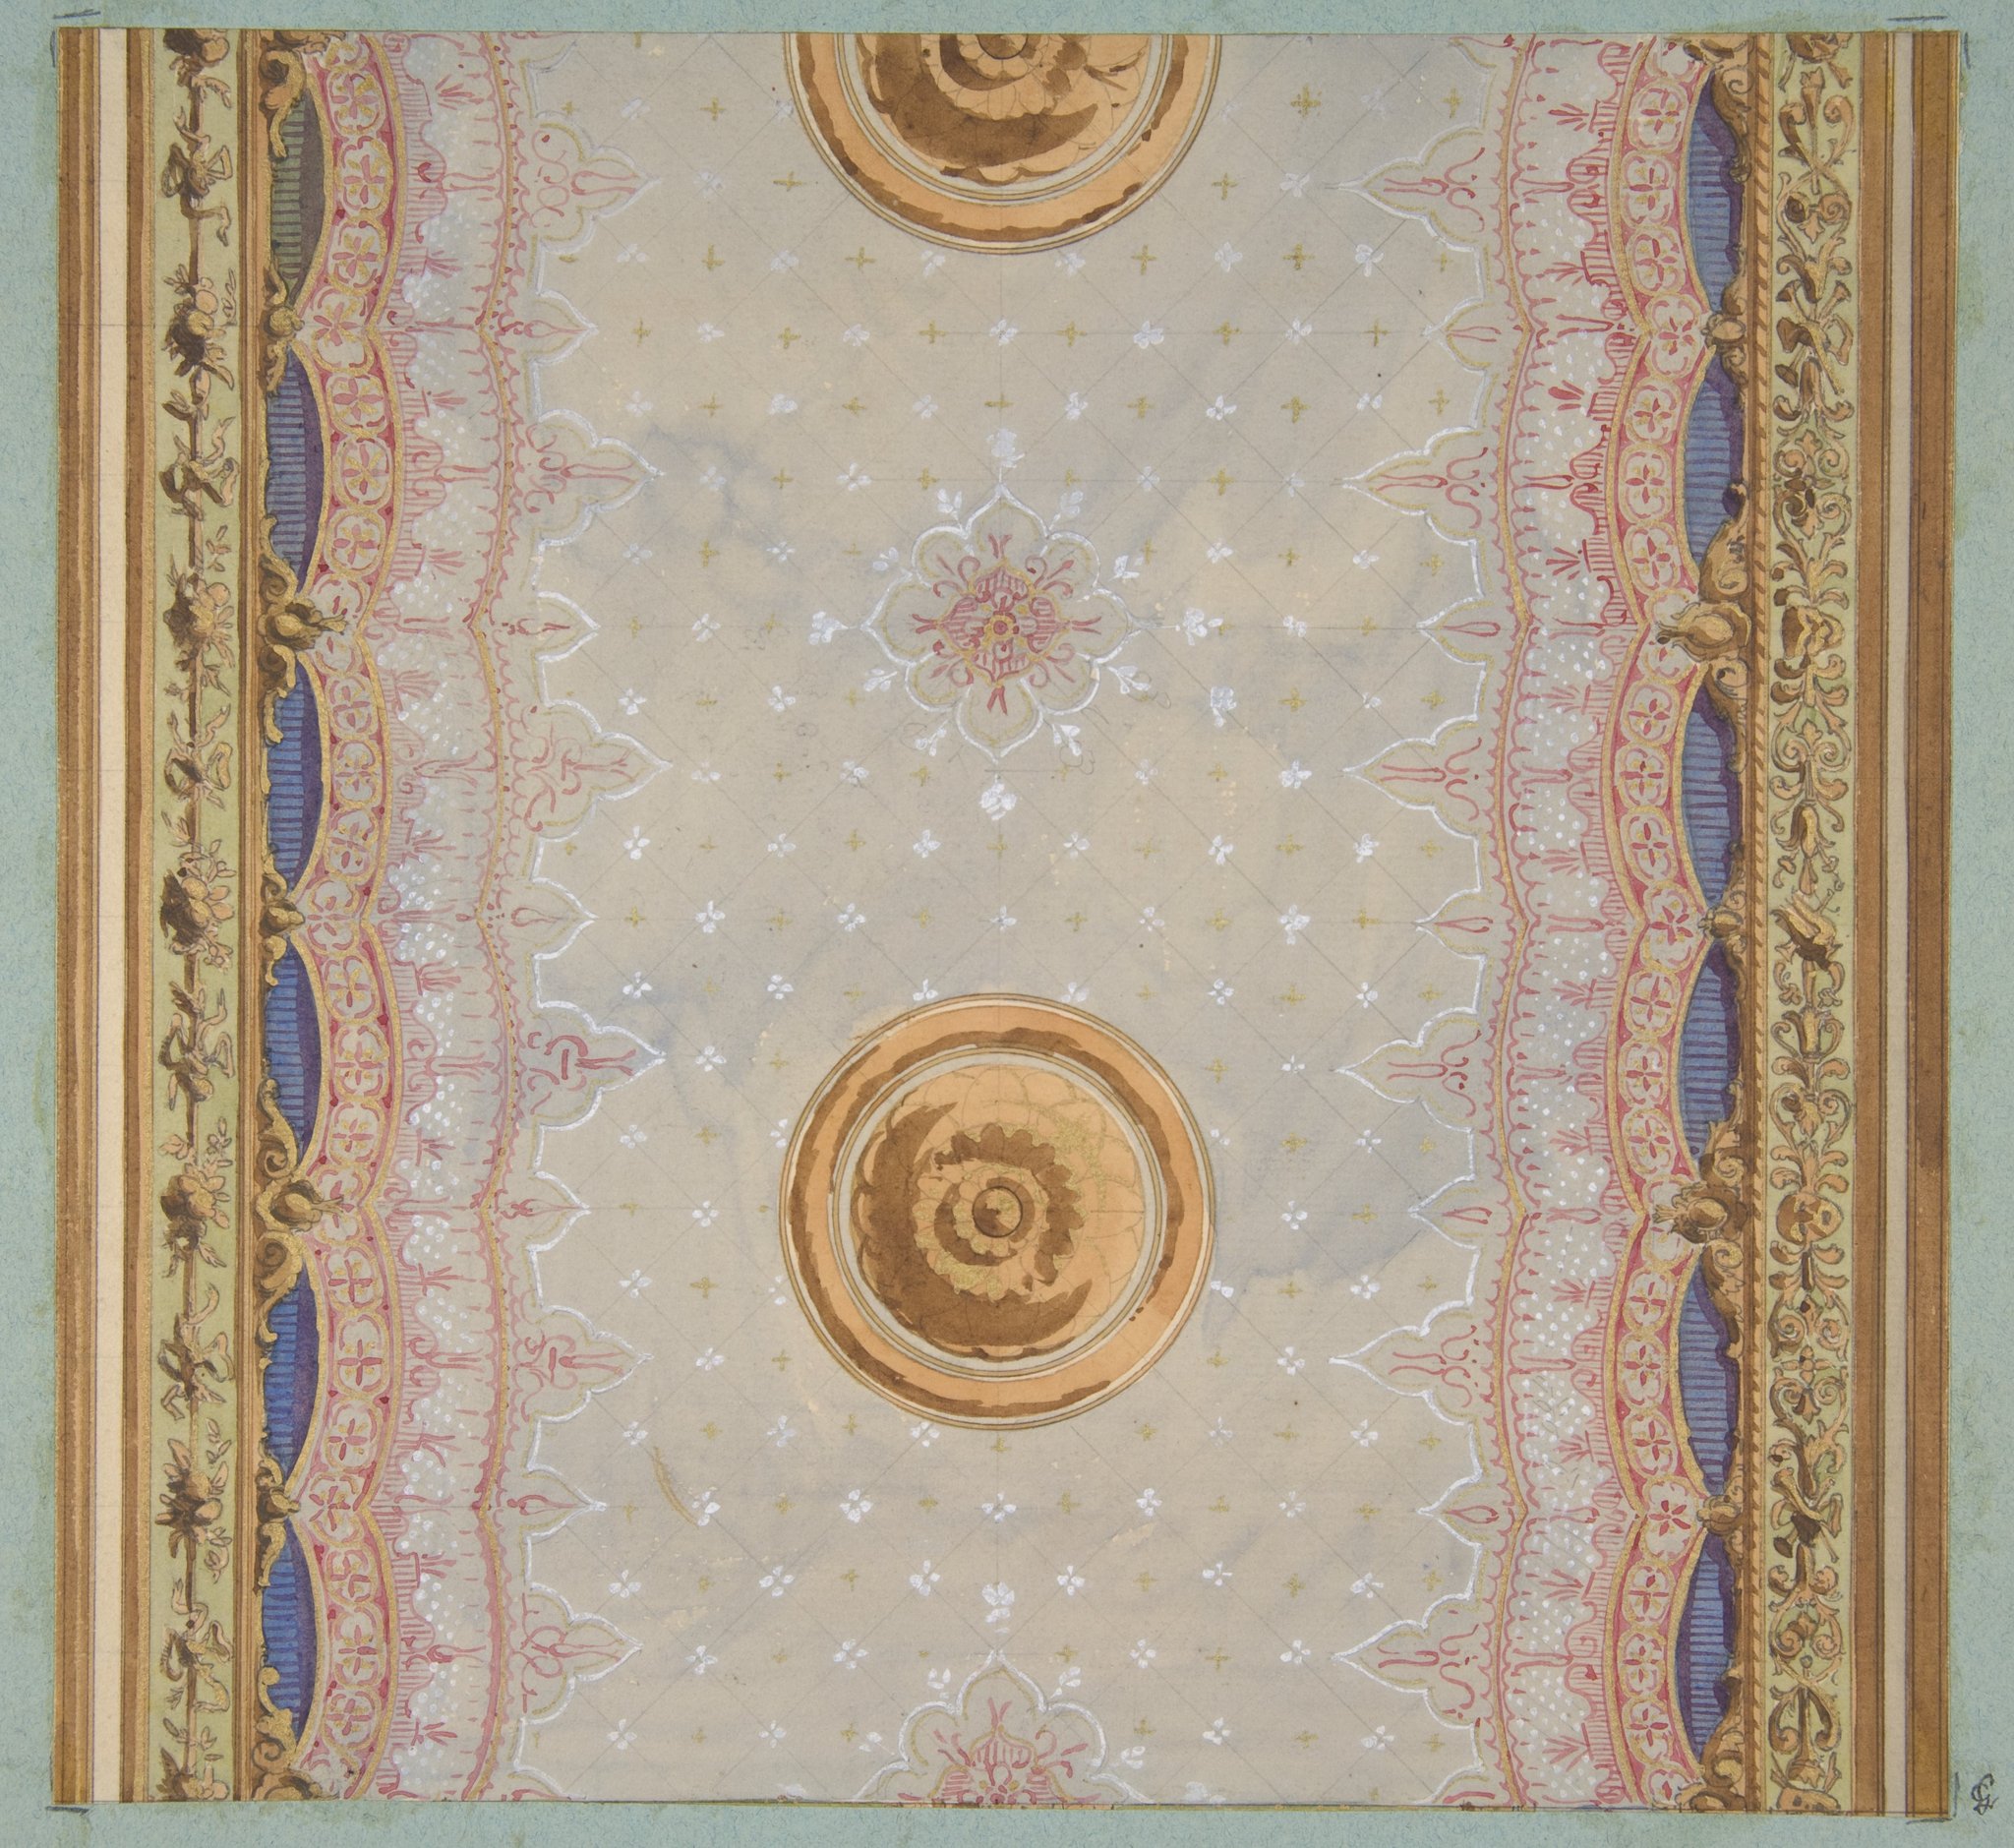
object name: drawing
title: A design for the painted decoration of a ceiling or walls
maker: jules-edmond-charles lachaise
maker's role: artist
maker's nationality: french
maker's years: 1897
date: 1830-1897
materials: gold paint, graphite, ink, paper, watercolor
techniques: pen